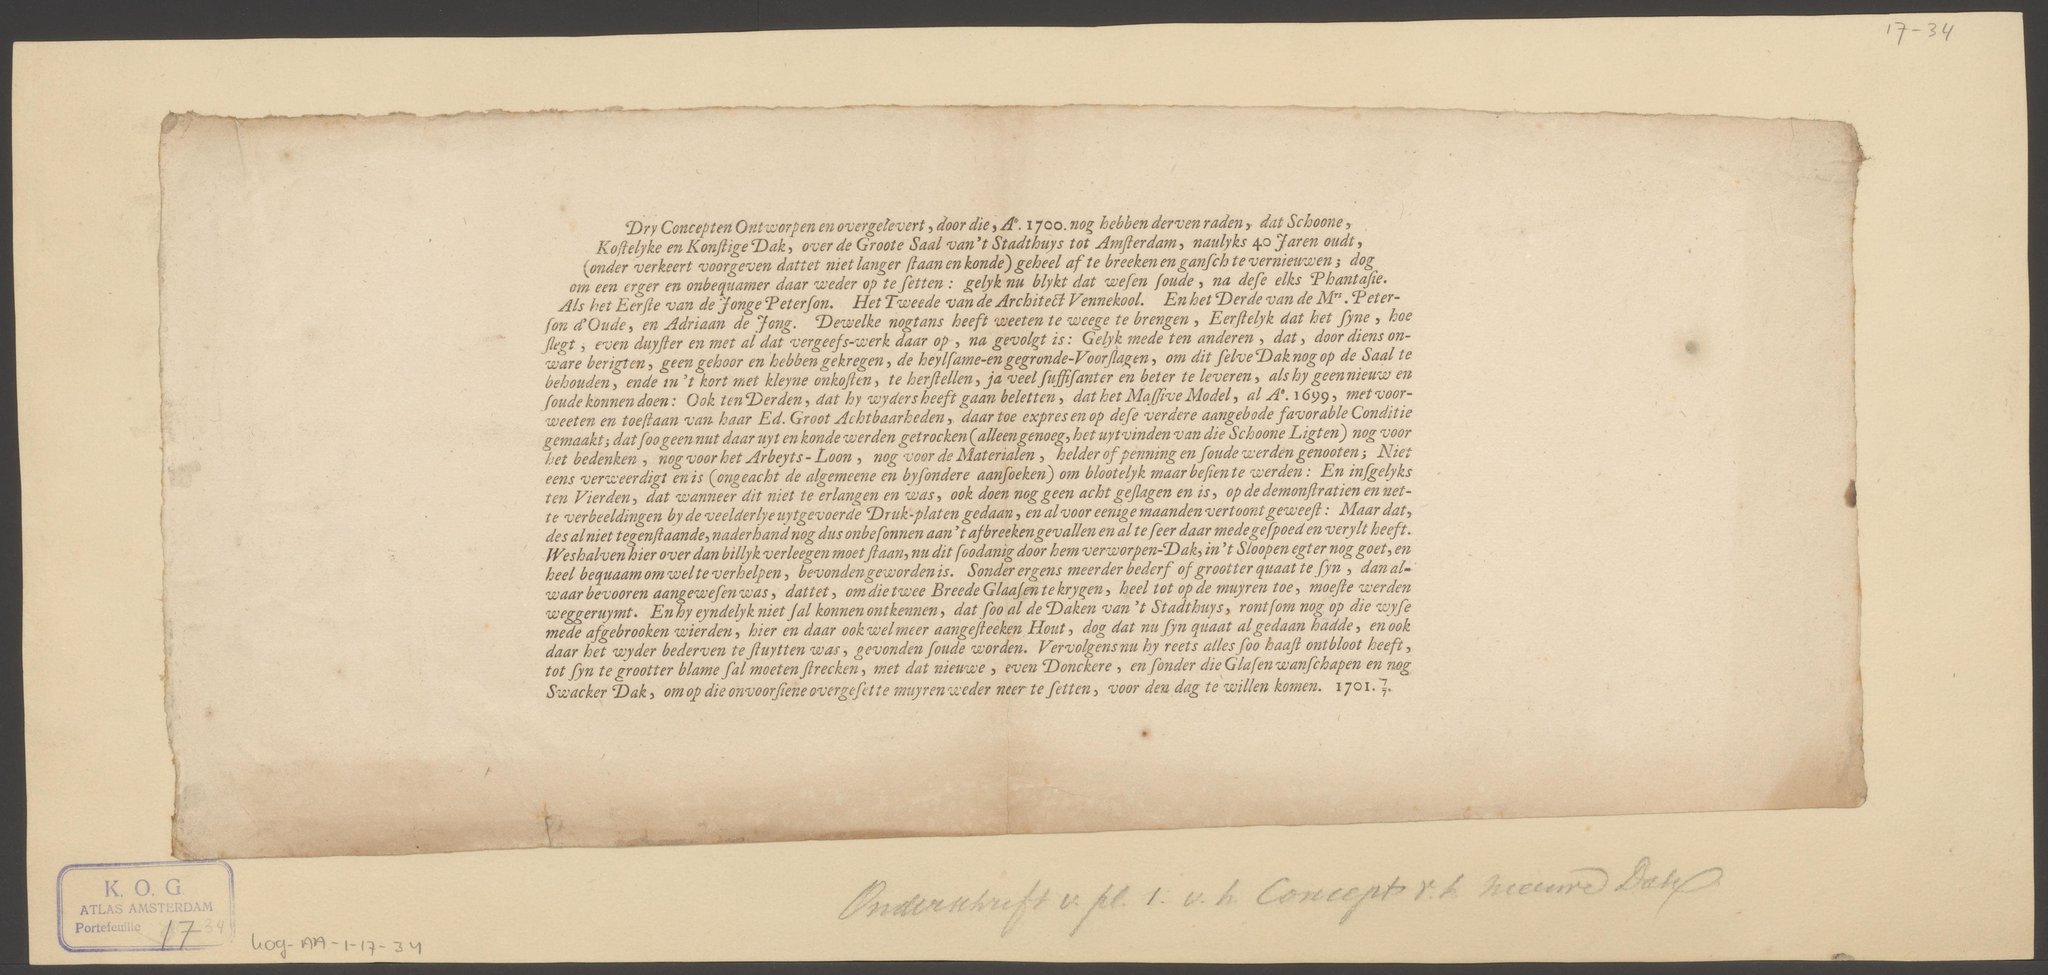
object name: text sheet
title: Tekst over het concept van het nieuwe dak van het Stadhuis op de Dam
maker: Anonymous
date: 1670-1750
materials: paper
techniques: letterpress printing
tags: roof (of house or building), townhall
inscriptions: collector's mark: ‘17 34’ Lugt 1641b, inscription: ‘Onderschrift v. pl. 1: v.h. Concept v.h. nieuwe Dak’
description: Onderwerpsrubriek binnen de Atlas Amsterdam: Nieuwe Stadhuis, van binnen: Kap, Plattegronden, Betimmering.